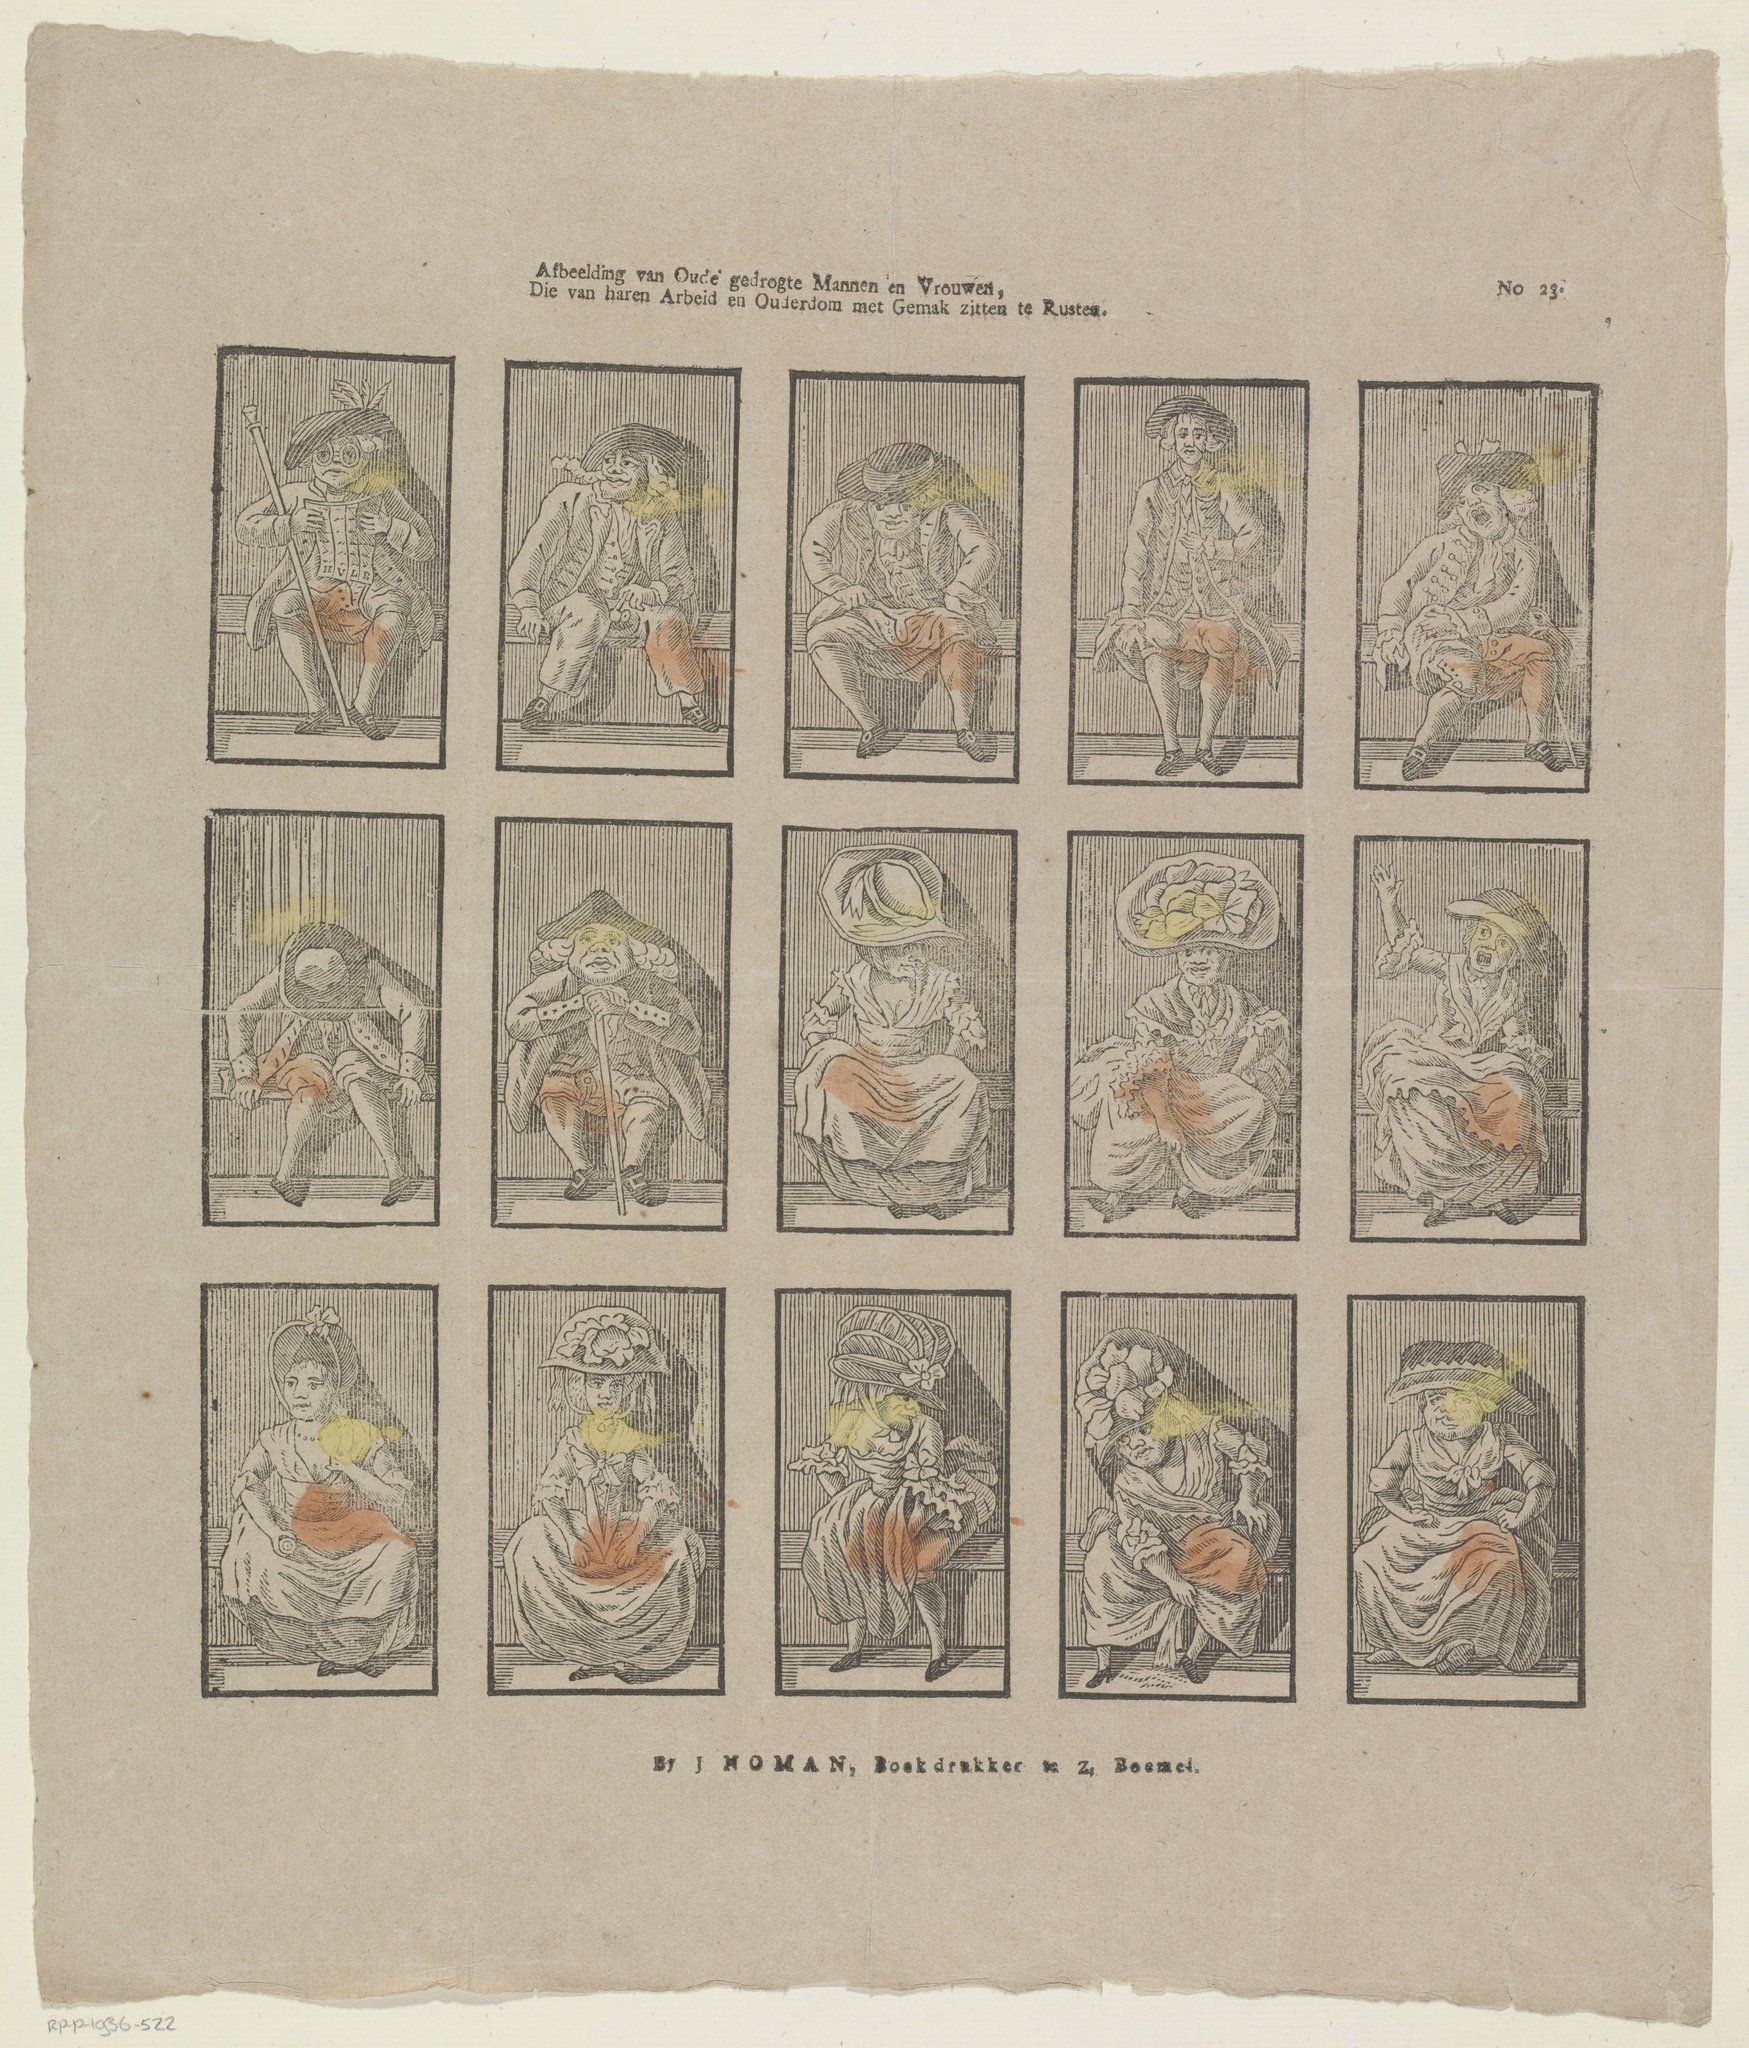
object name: popular print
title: Afbeelding van oude gedrogte mannen en vrouwen, / Die van haren arbeid en ouderdom met gemak zitten te rusten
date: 1806-1830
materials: paper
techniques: colour, letterpress printing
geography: zaltbommel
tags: lavatory, water-closet, defecation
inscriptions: collector's mark: Lugt 2228, collector's mark: Lugt 2760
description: Blad 15 voorstellingen van mannen en vrouwen op het toilet. Genummerd rechtsboven: No. 23.